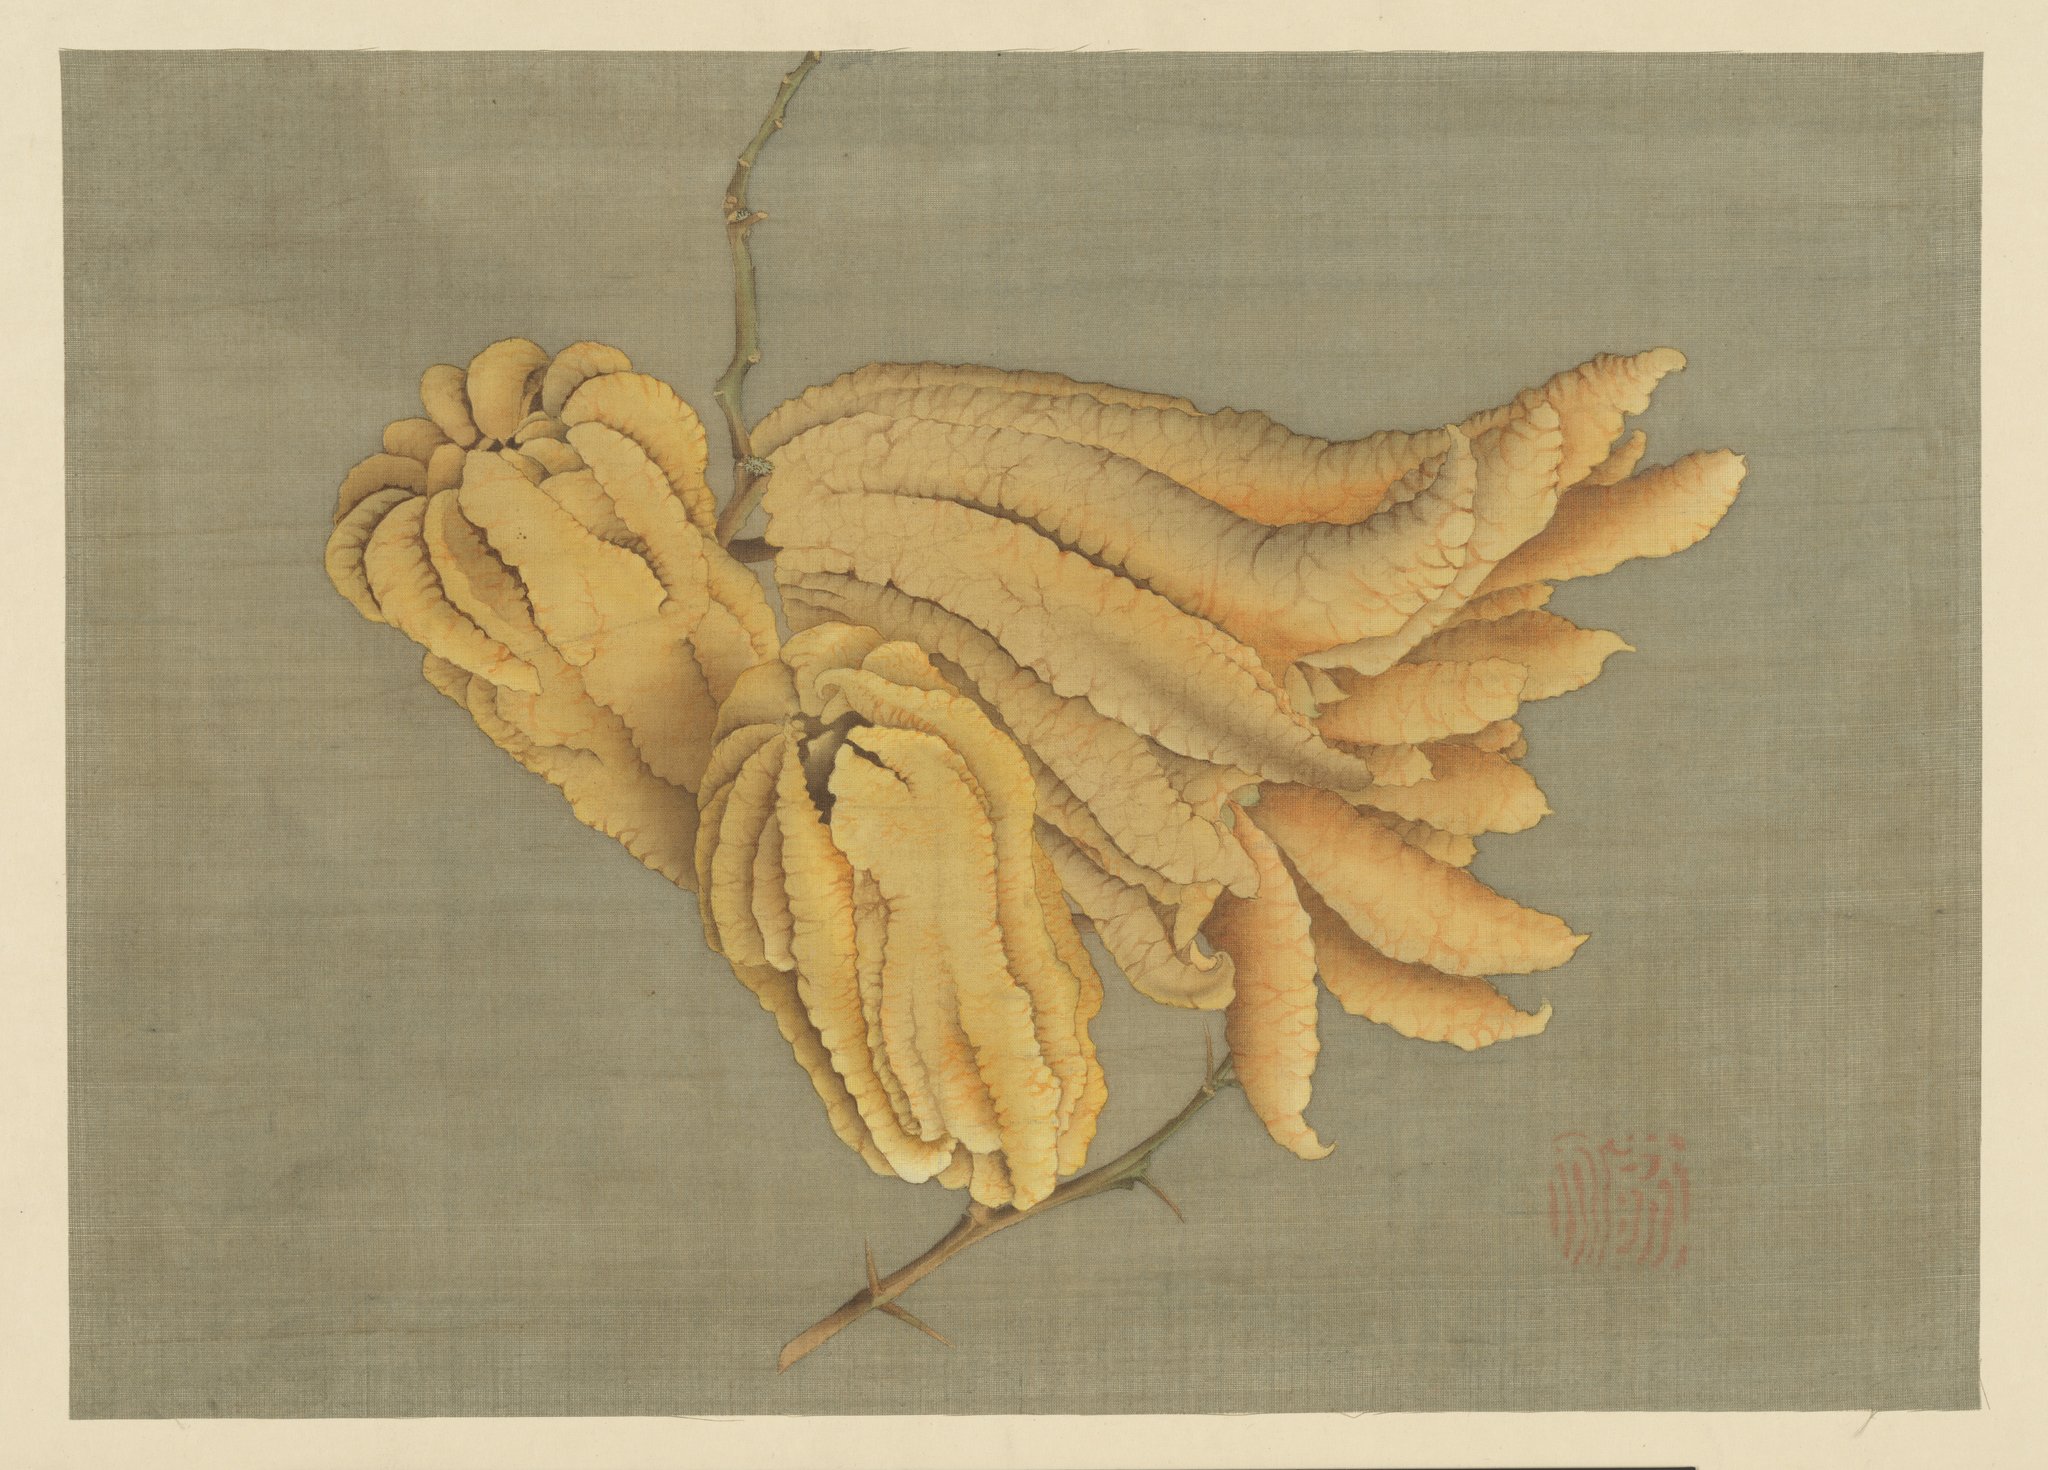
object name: painting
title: Buddha’s Hand Citron (Busshukan)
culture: japanese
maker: katsushika hokusai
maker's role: artist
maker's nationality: japanese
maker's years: 1760-1849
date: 1834-1866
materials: ink, silk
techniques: painting